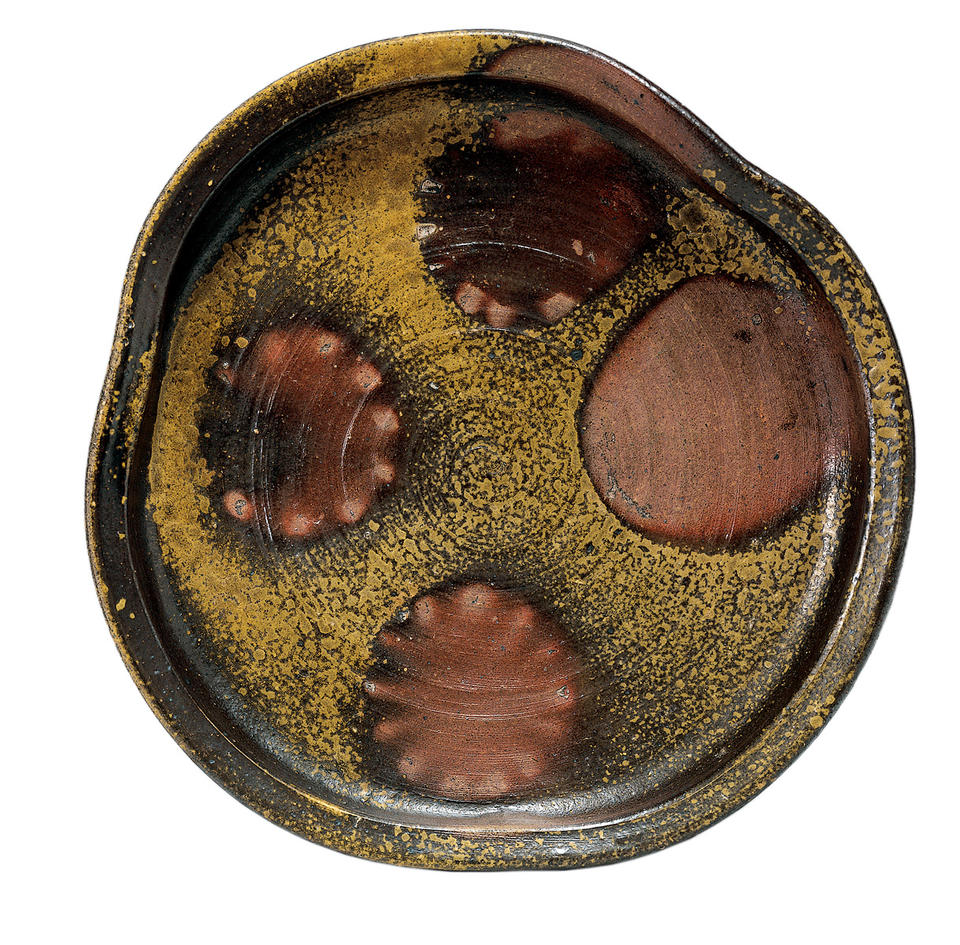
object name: serving dish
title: Serving Dish (Hirabachi) with Circular Patterns (Botan-mochi)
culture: japanese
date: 1601-1633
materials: wood, glaze, stoneware